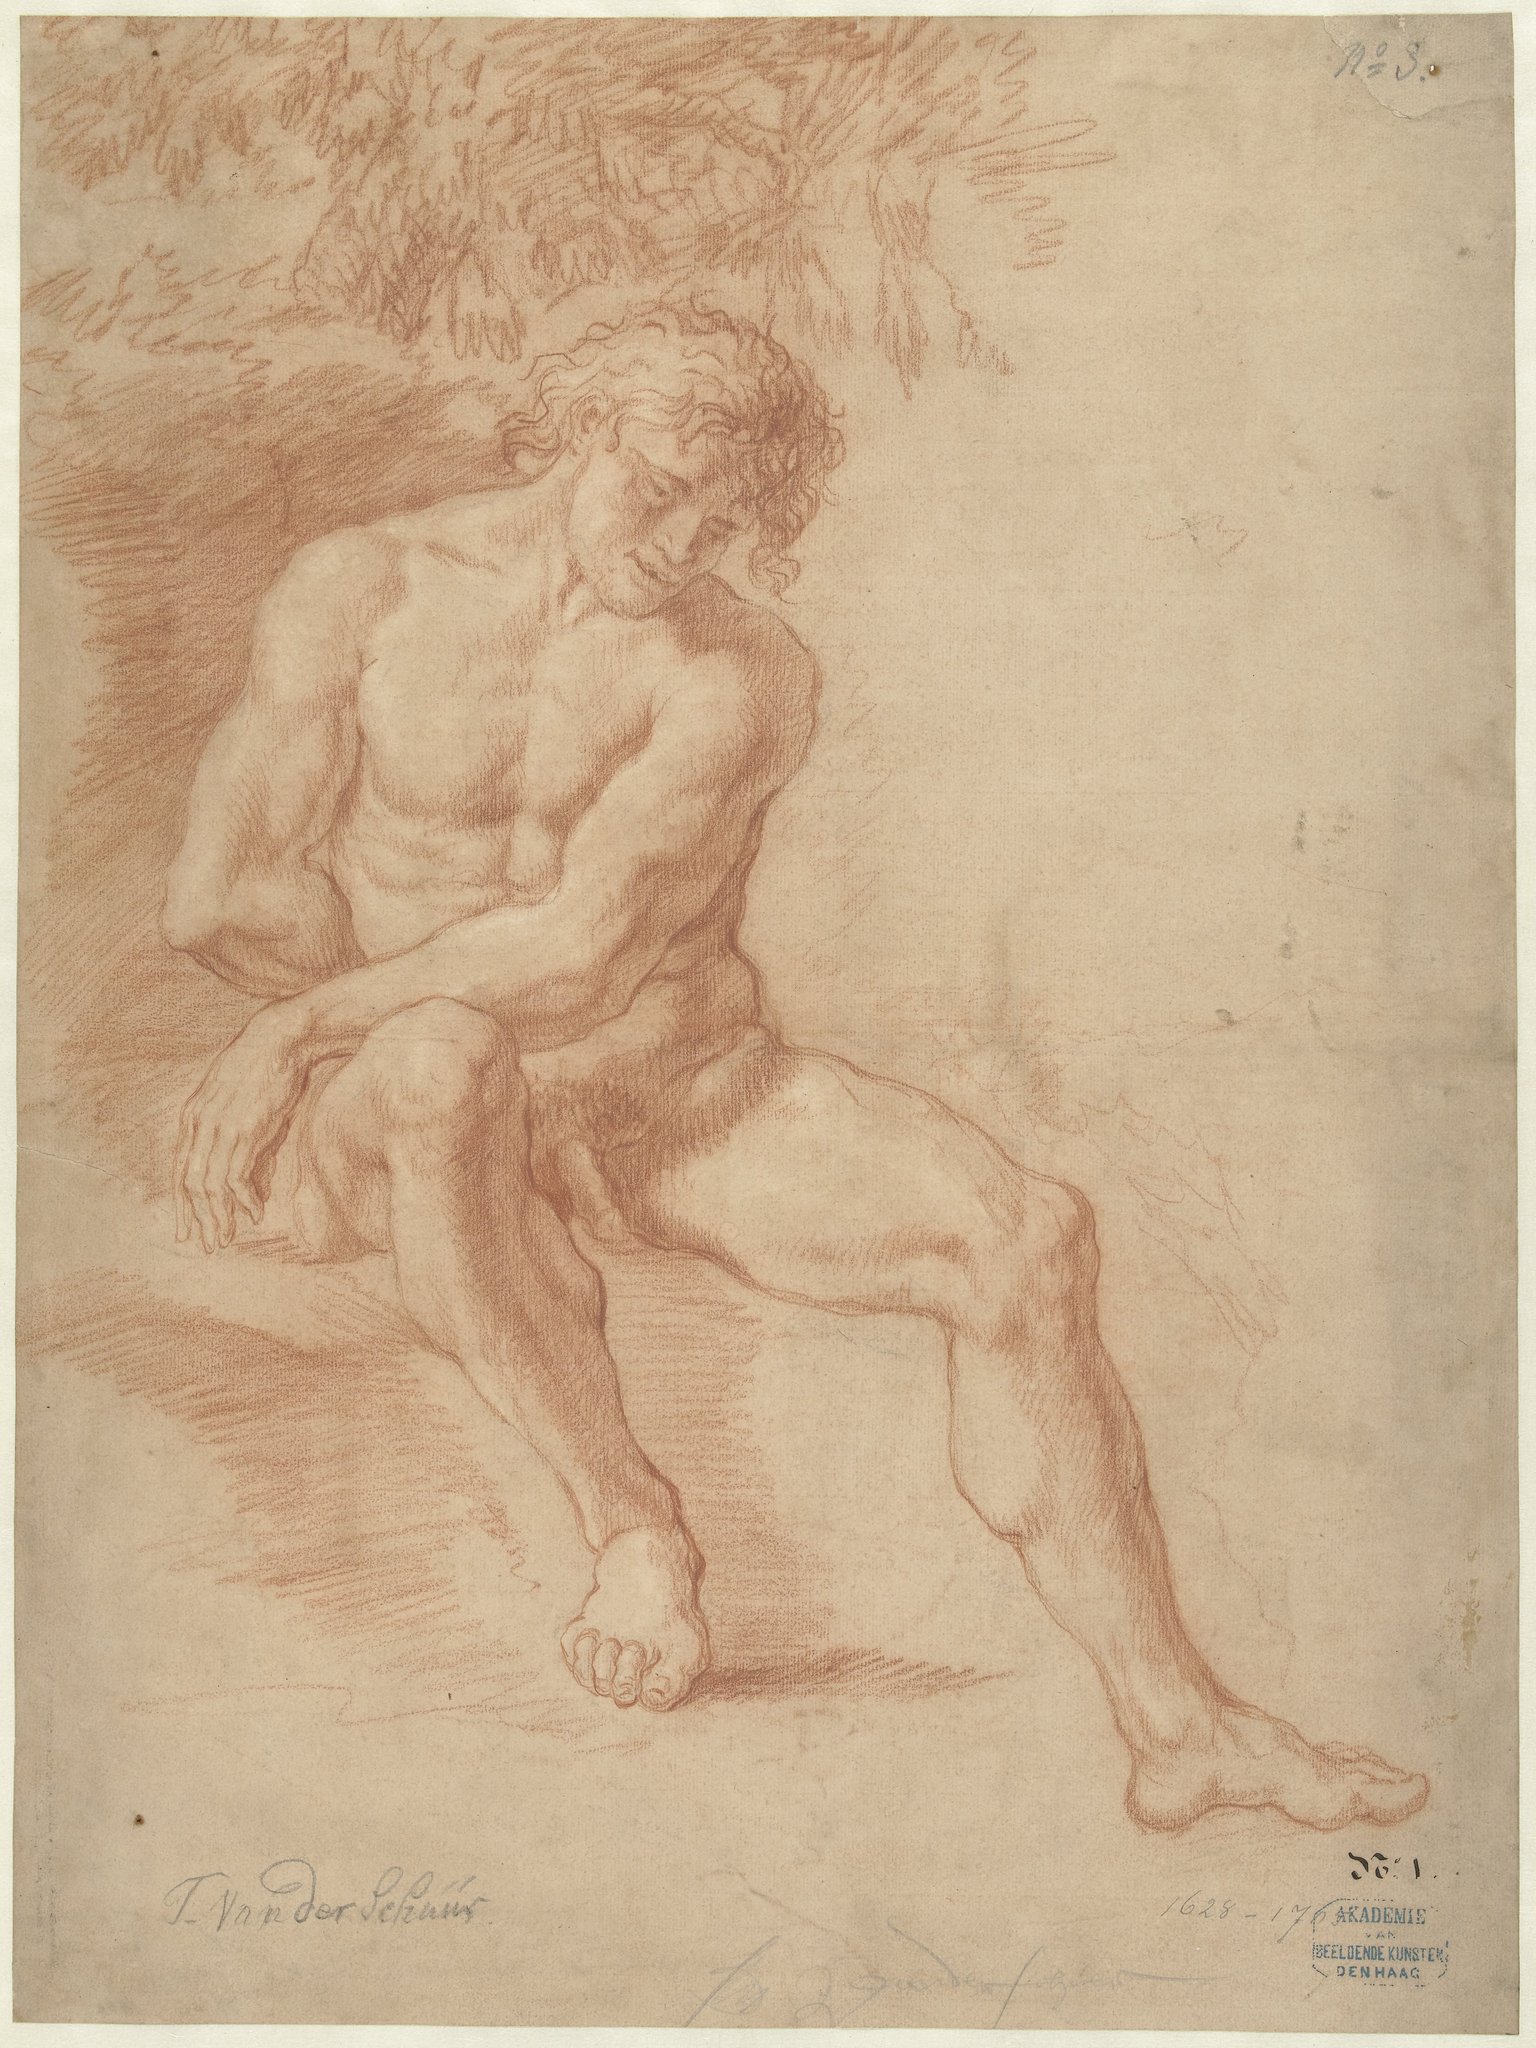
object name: drawing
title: Zittend mannelijk naakt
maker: theodoor van der schuer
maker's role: draughtsman, painter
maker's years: 1634-1707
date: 1638-1707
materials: chalk, paper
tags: sitting figure